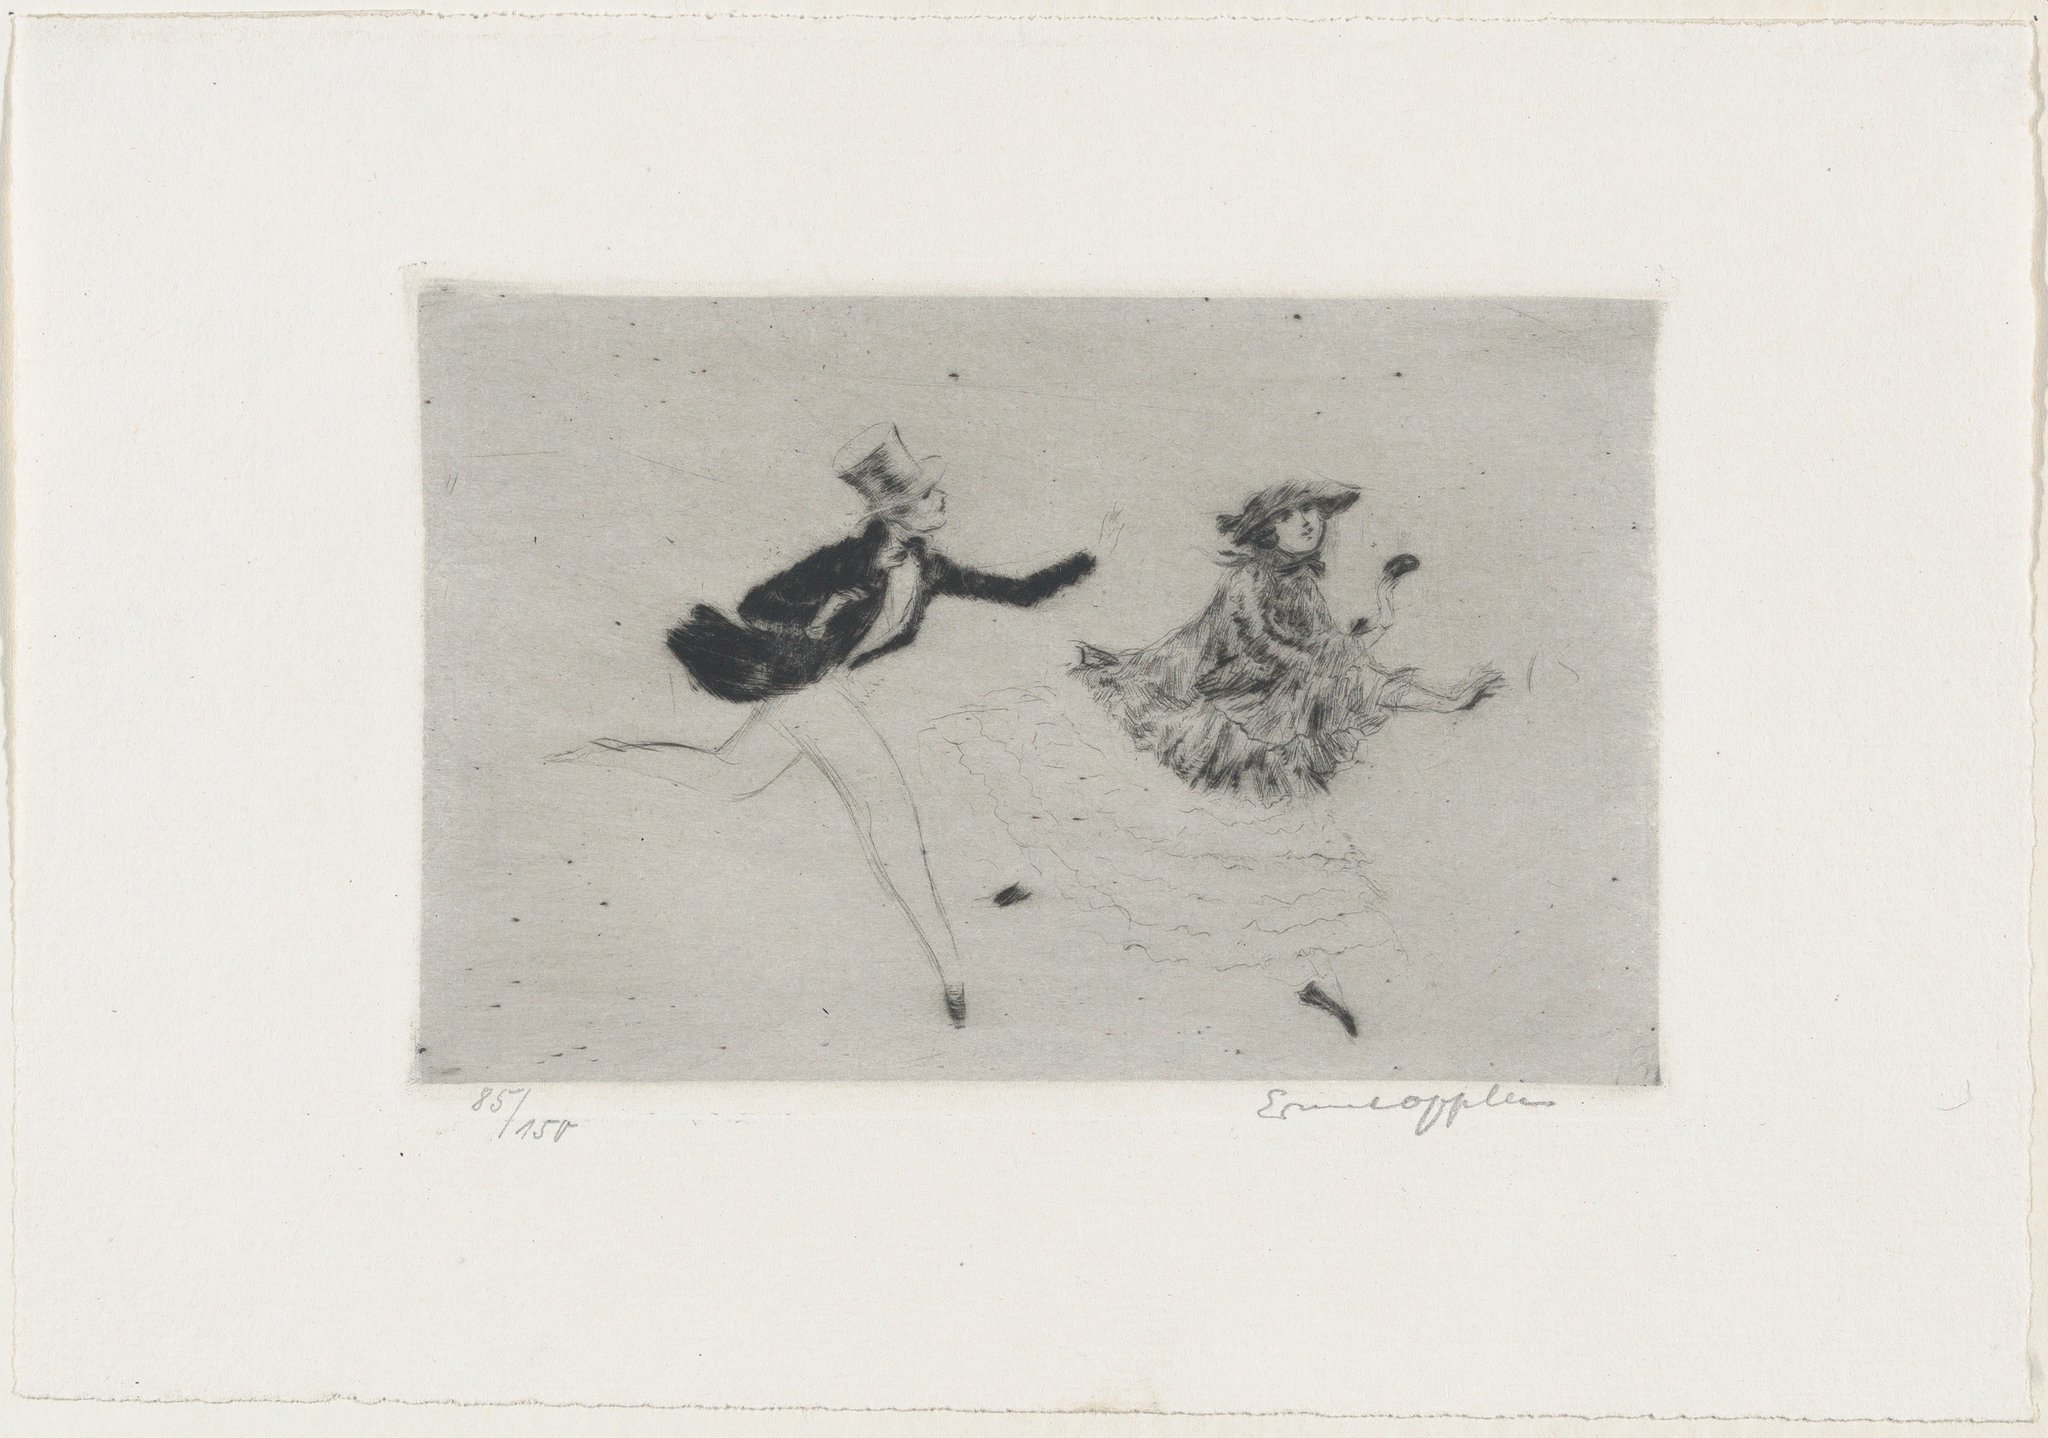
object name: print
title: Demaskiert (Unmasks)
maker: ernst oppler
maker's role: artist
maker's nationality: german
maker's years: 1867-1929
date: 1921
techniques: etching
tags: men,women,running